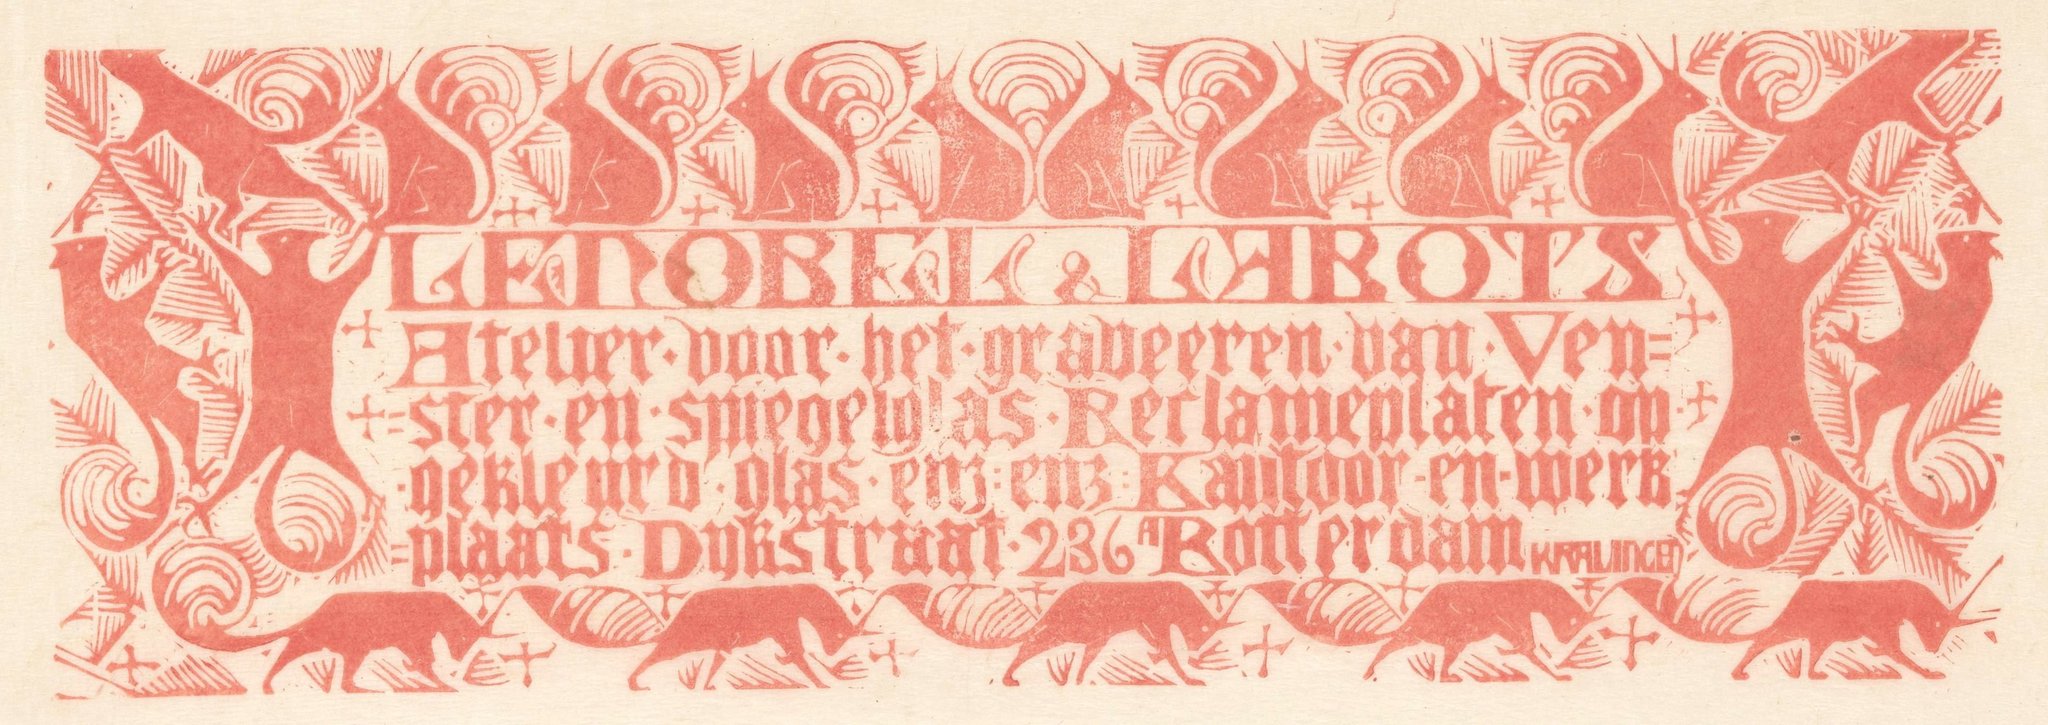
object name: letterhead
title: Briefhoofd van Le Nobel & Labots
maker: mathieu lauweriks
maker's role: designer, draughtsman, print maker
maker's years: 1864-1932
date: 1874-1932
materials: paper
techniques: woodcut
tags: hoofed animals: deer, rodents: squirrel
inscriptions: collector's mark: Lugt 2228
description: Briefhoofd van het atelier Le Nobel & Labots met een ornamentrand met eekhoorns en herten.